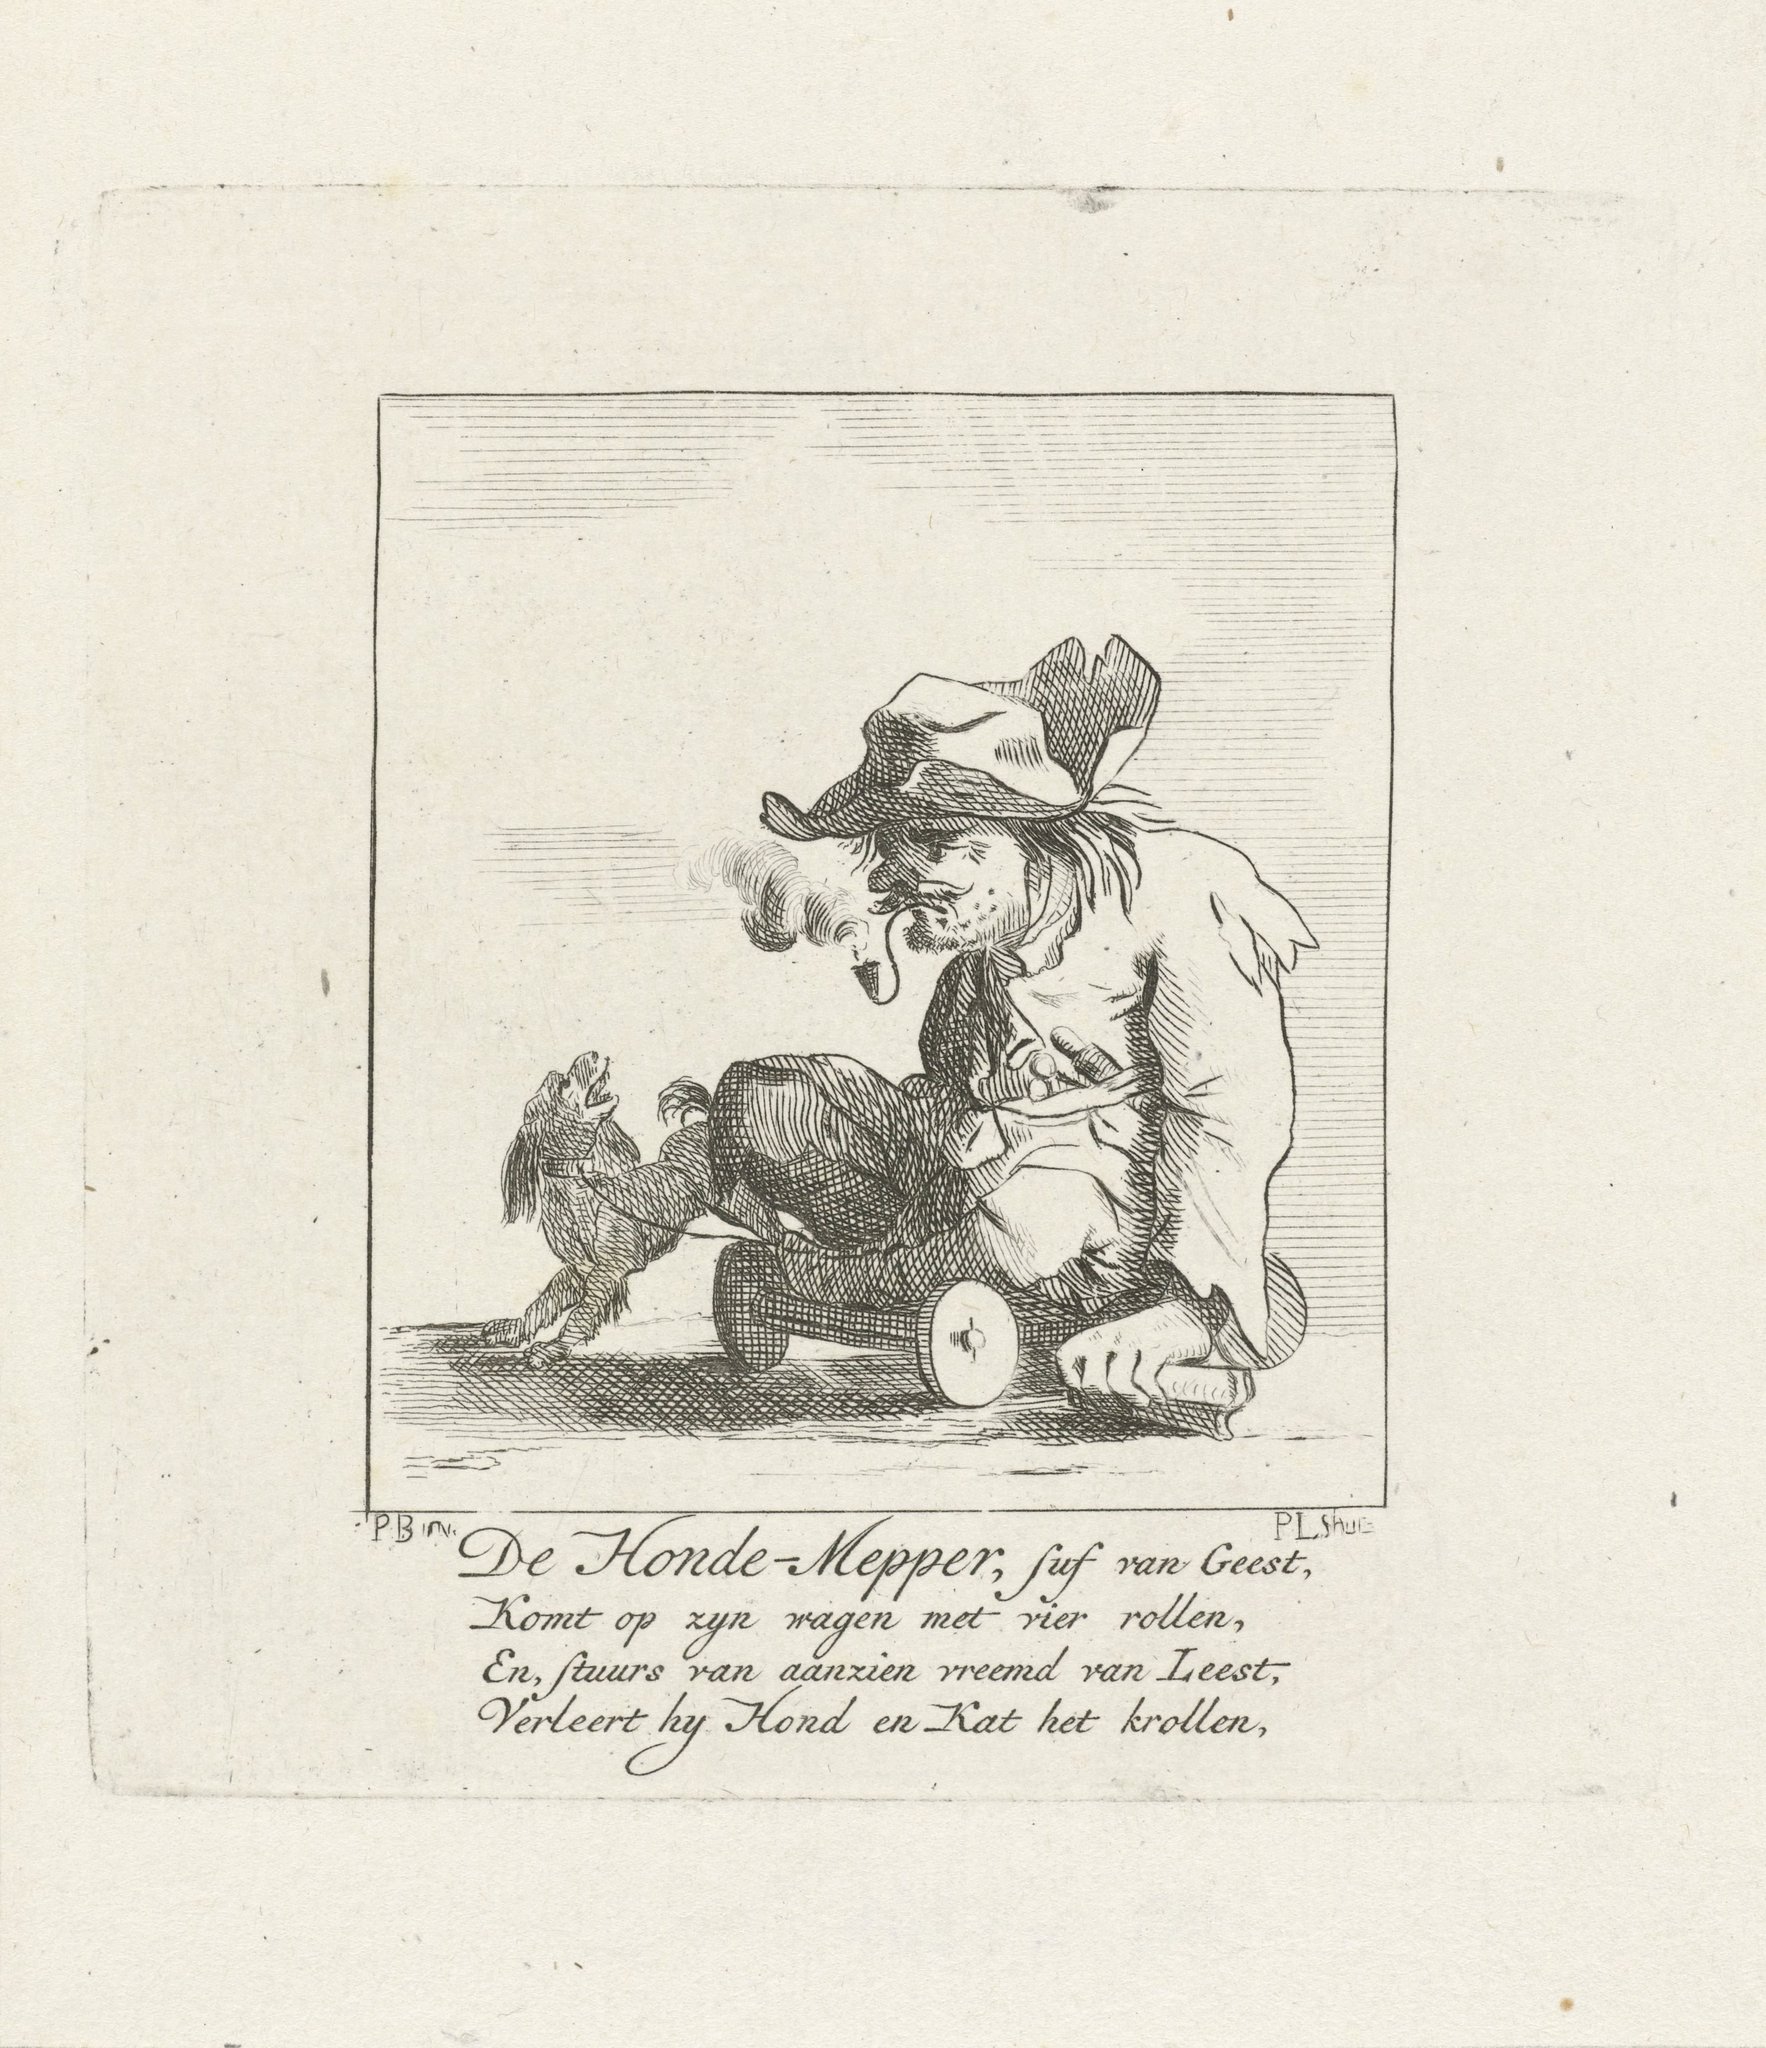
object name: print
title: Amsterdamse straatfiguren rond 1770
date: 1770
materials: paper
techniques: engraving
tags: pipe ~ tobacco, person with a physical disability, beggar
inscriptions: collector's mark: Lugt 240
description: Een kreupele bedelaar zit op een klein karretje pijp te roken en wordt vergezeld door een hond. In de marge een vierregelig vers in het Nederlands. Onderdeel van een serie prenten van Amsterdamse straatfiguren rond 1770.